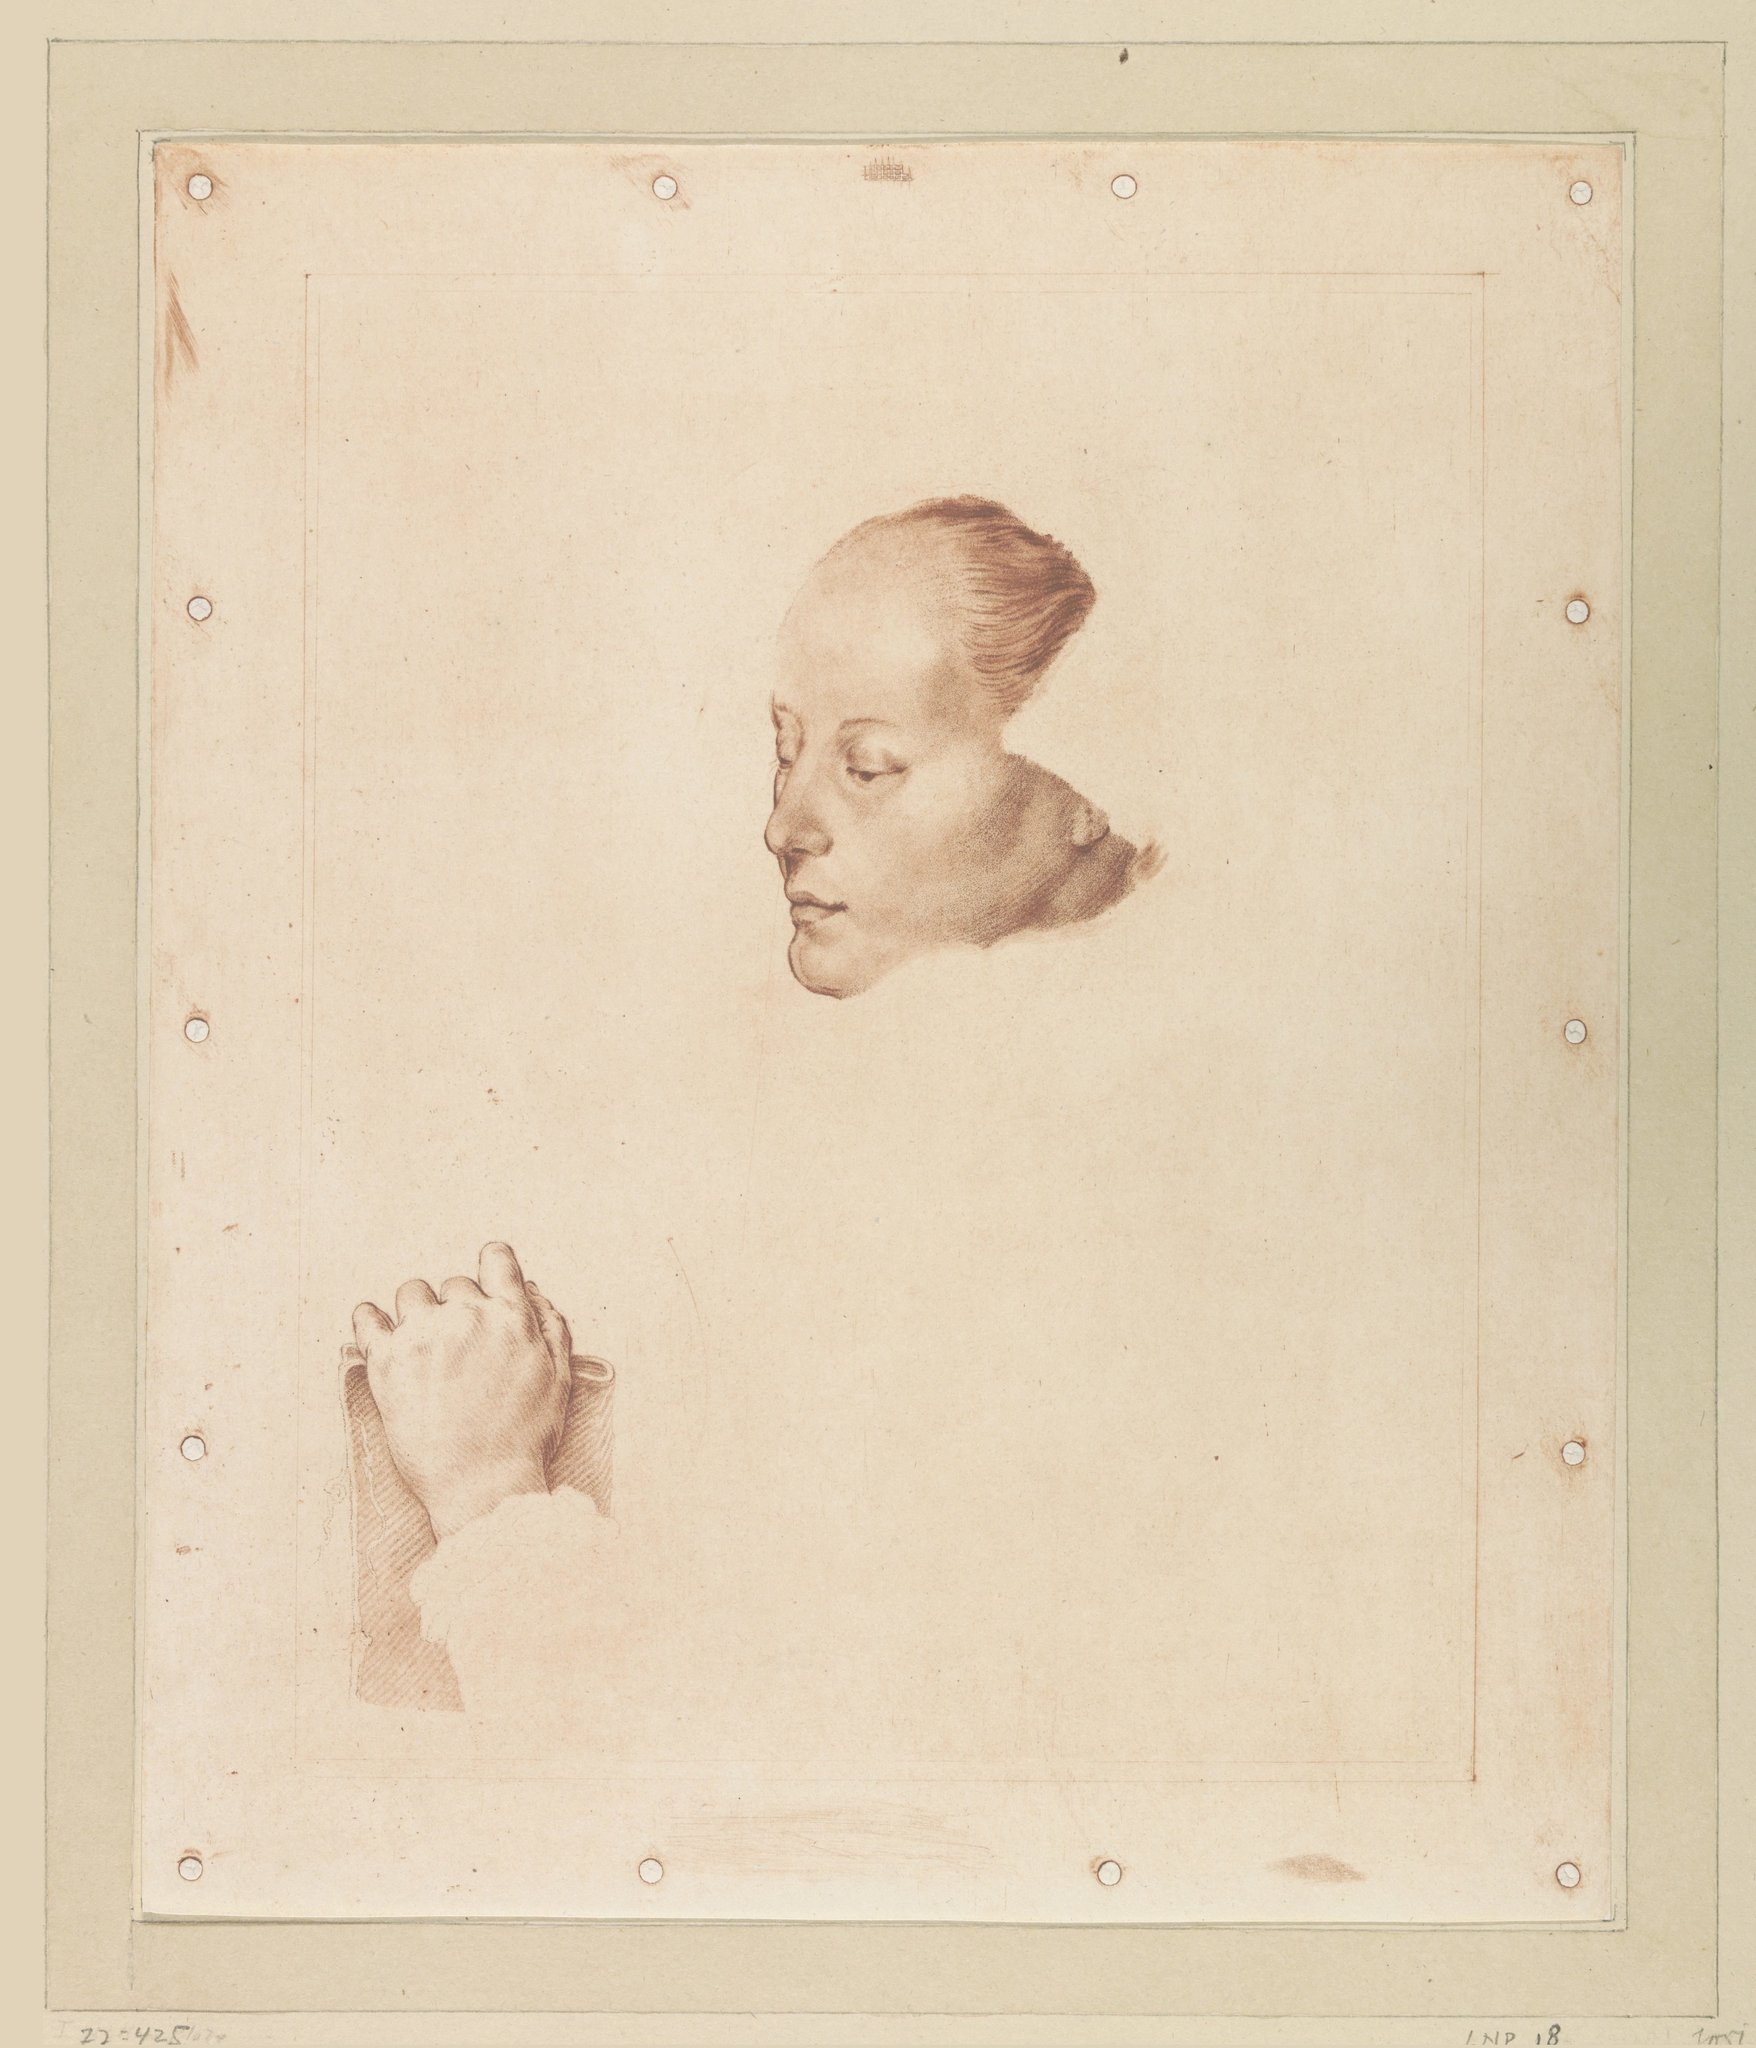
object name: print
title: Portret van een jonge vrouw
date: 1770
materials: paper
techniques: printmaking, etching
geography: amsterdam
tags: maria tesselschade roemers visscher, adult woman, book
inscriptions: collector's mark: Lugt 2228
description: Naar een tekening van Hendrick Goltzius in het Amsterdam Museum. Vanaf de achttiende eeuw werd de geportretteerde, onder andere door Cornelis Ploos van Amstel, regelmatig aangeduid als zijnde Maria Tesselschade Roemer Visscher, maar dat is onjuist gebleken.